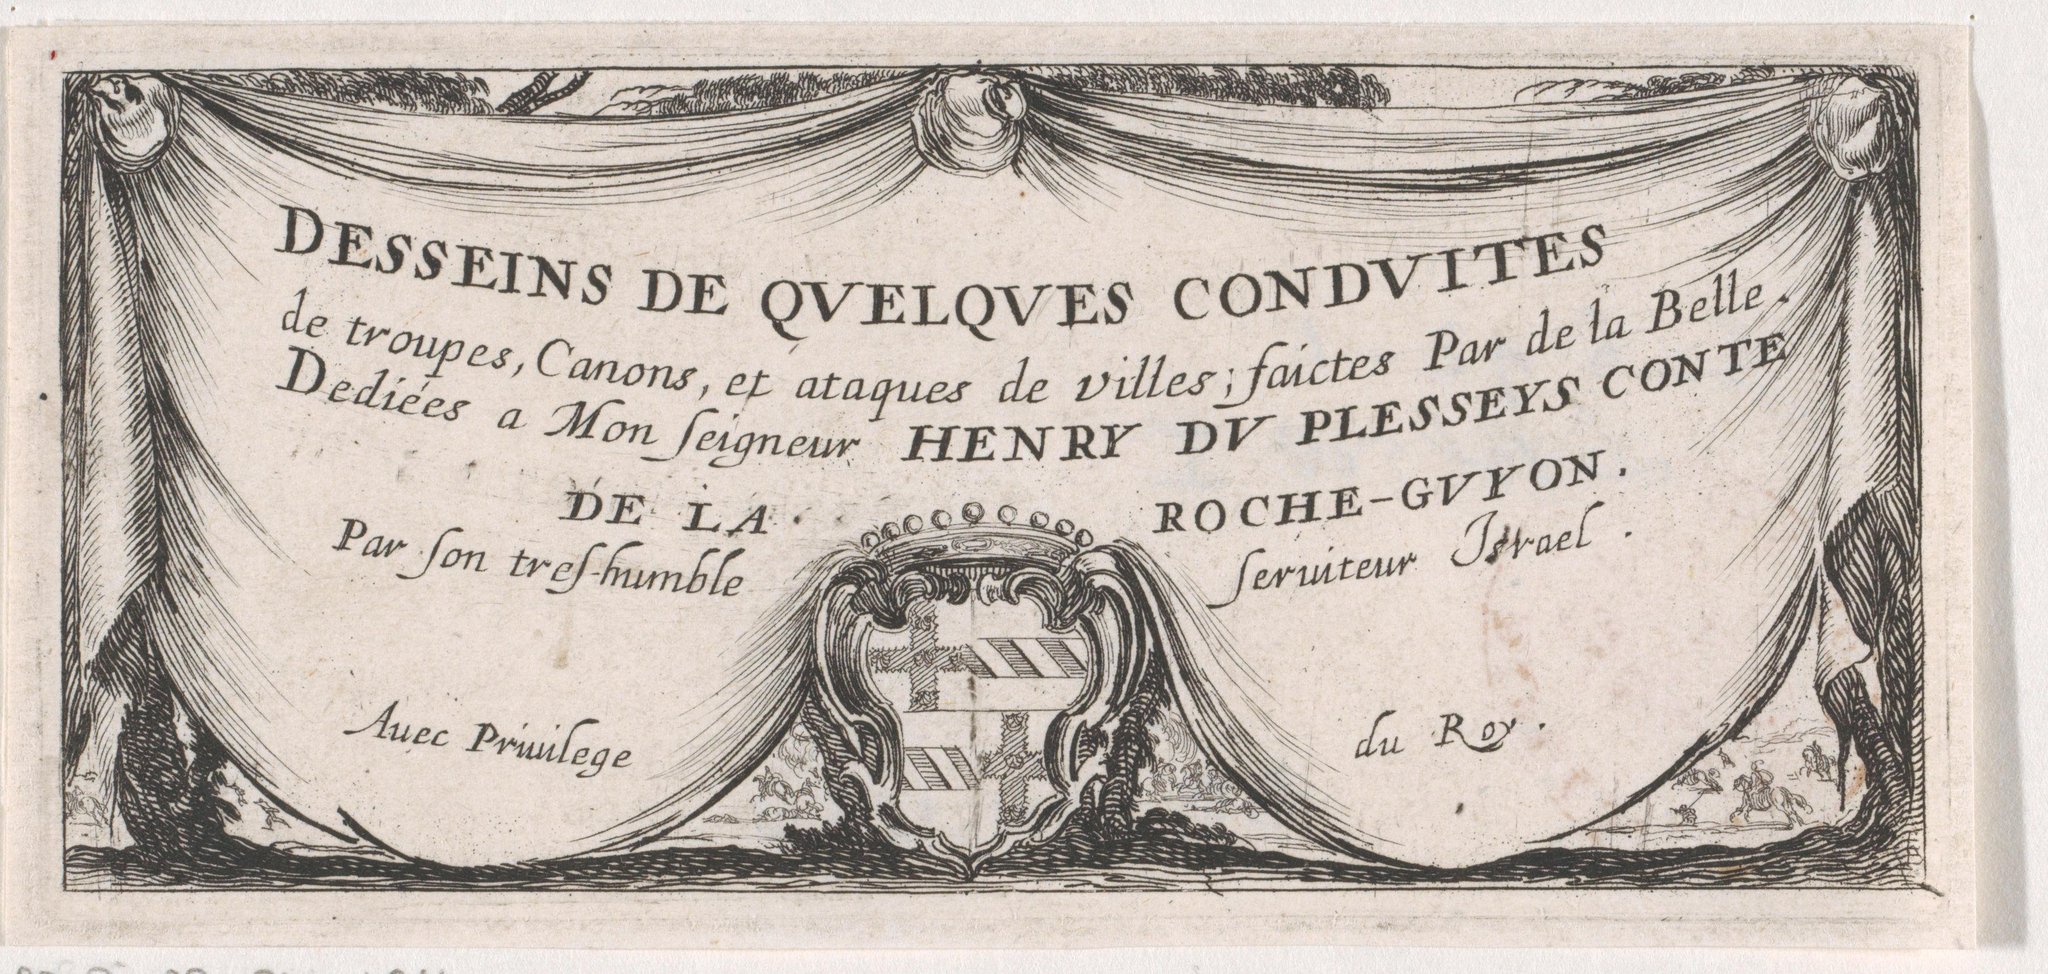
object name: print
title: Titelprent met gedrapeerd doek met tekst en wapenschild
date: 1620-1664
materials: paper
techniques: etching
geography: france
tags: coat of arms (as symbol of the state, etc.), hangings and drapery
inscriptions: collector's mark: Lugt 240